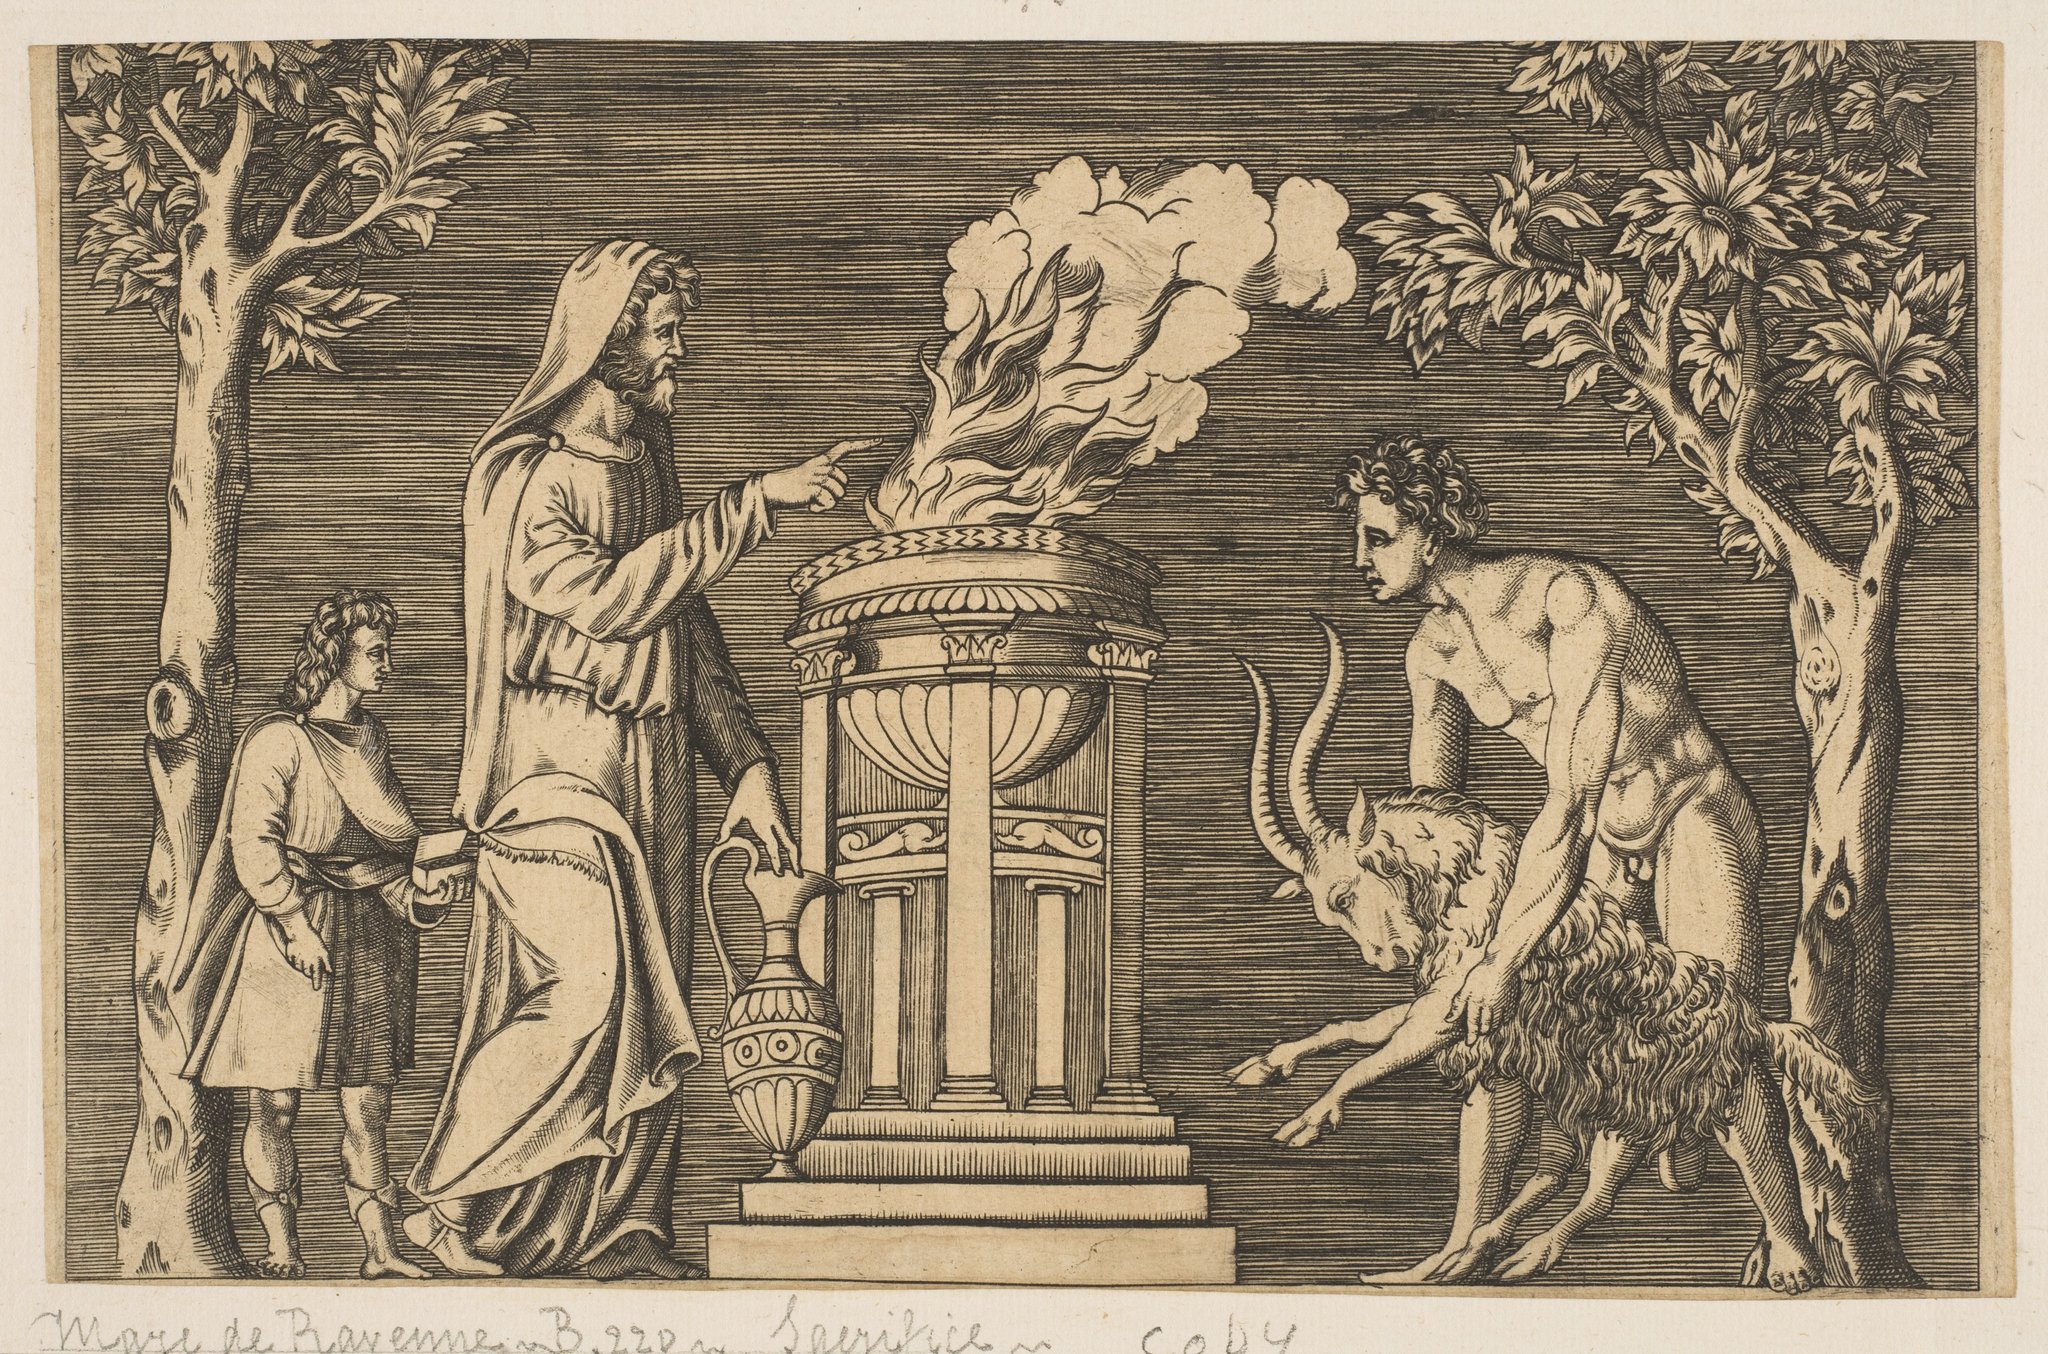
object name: print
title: The sacrifice of a ram held by a naked man at right, hooded priest at left with a young attendant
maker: anonymous, italian, 16th to early 17th century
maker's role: artist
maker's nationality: italian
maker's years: 1500-1640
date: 1515-1600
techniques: engraving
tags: men,male nudes,rams,fire,trees